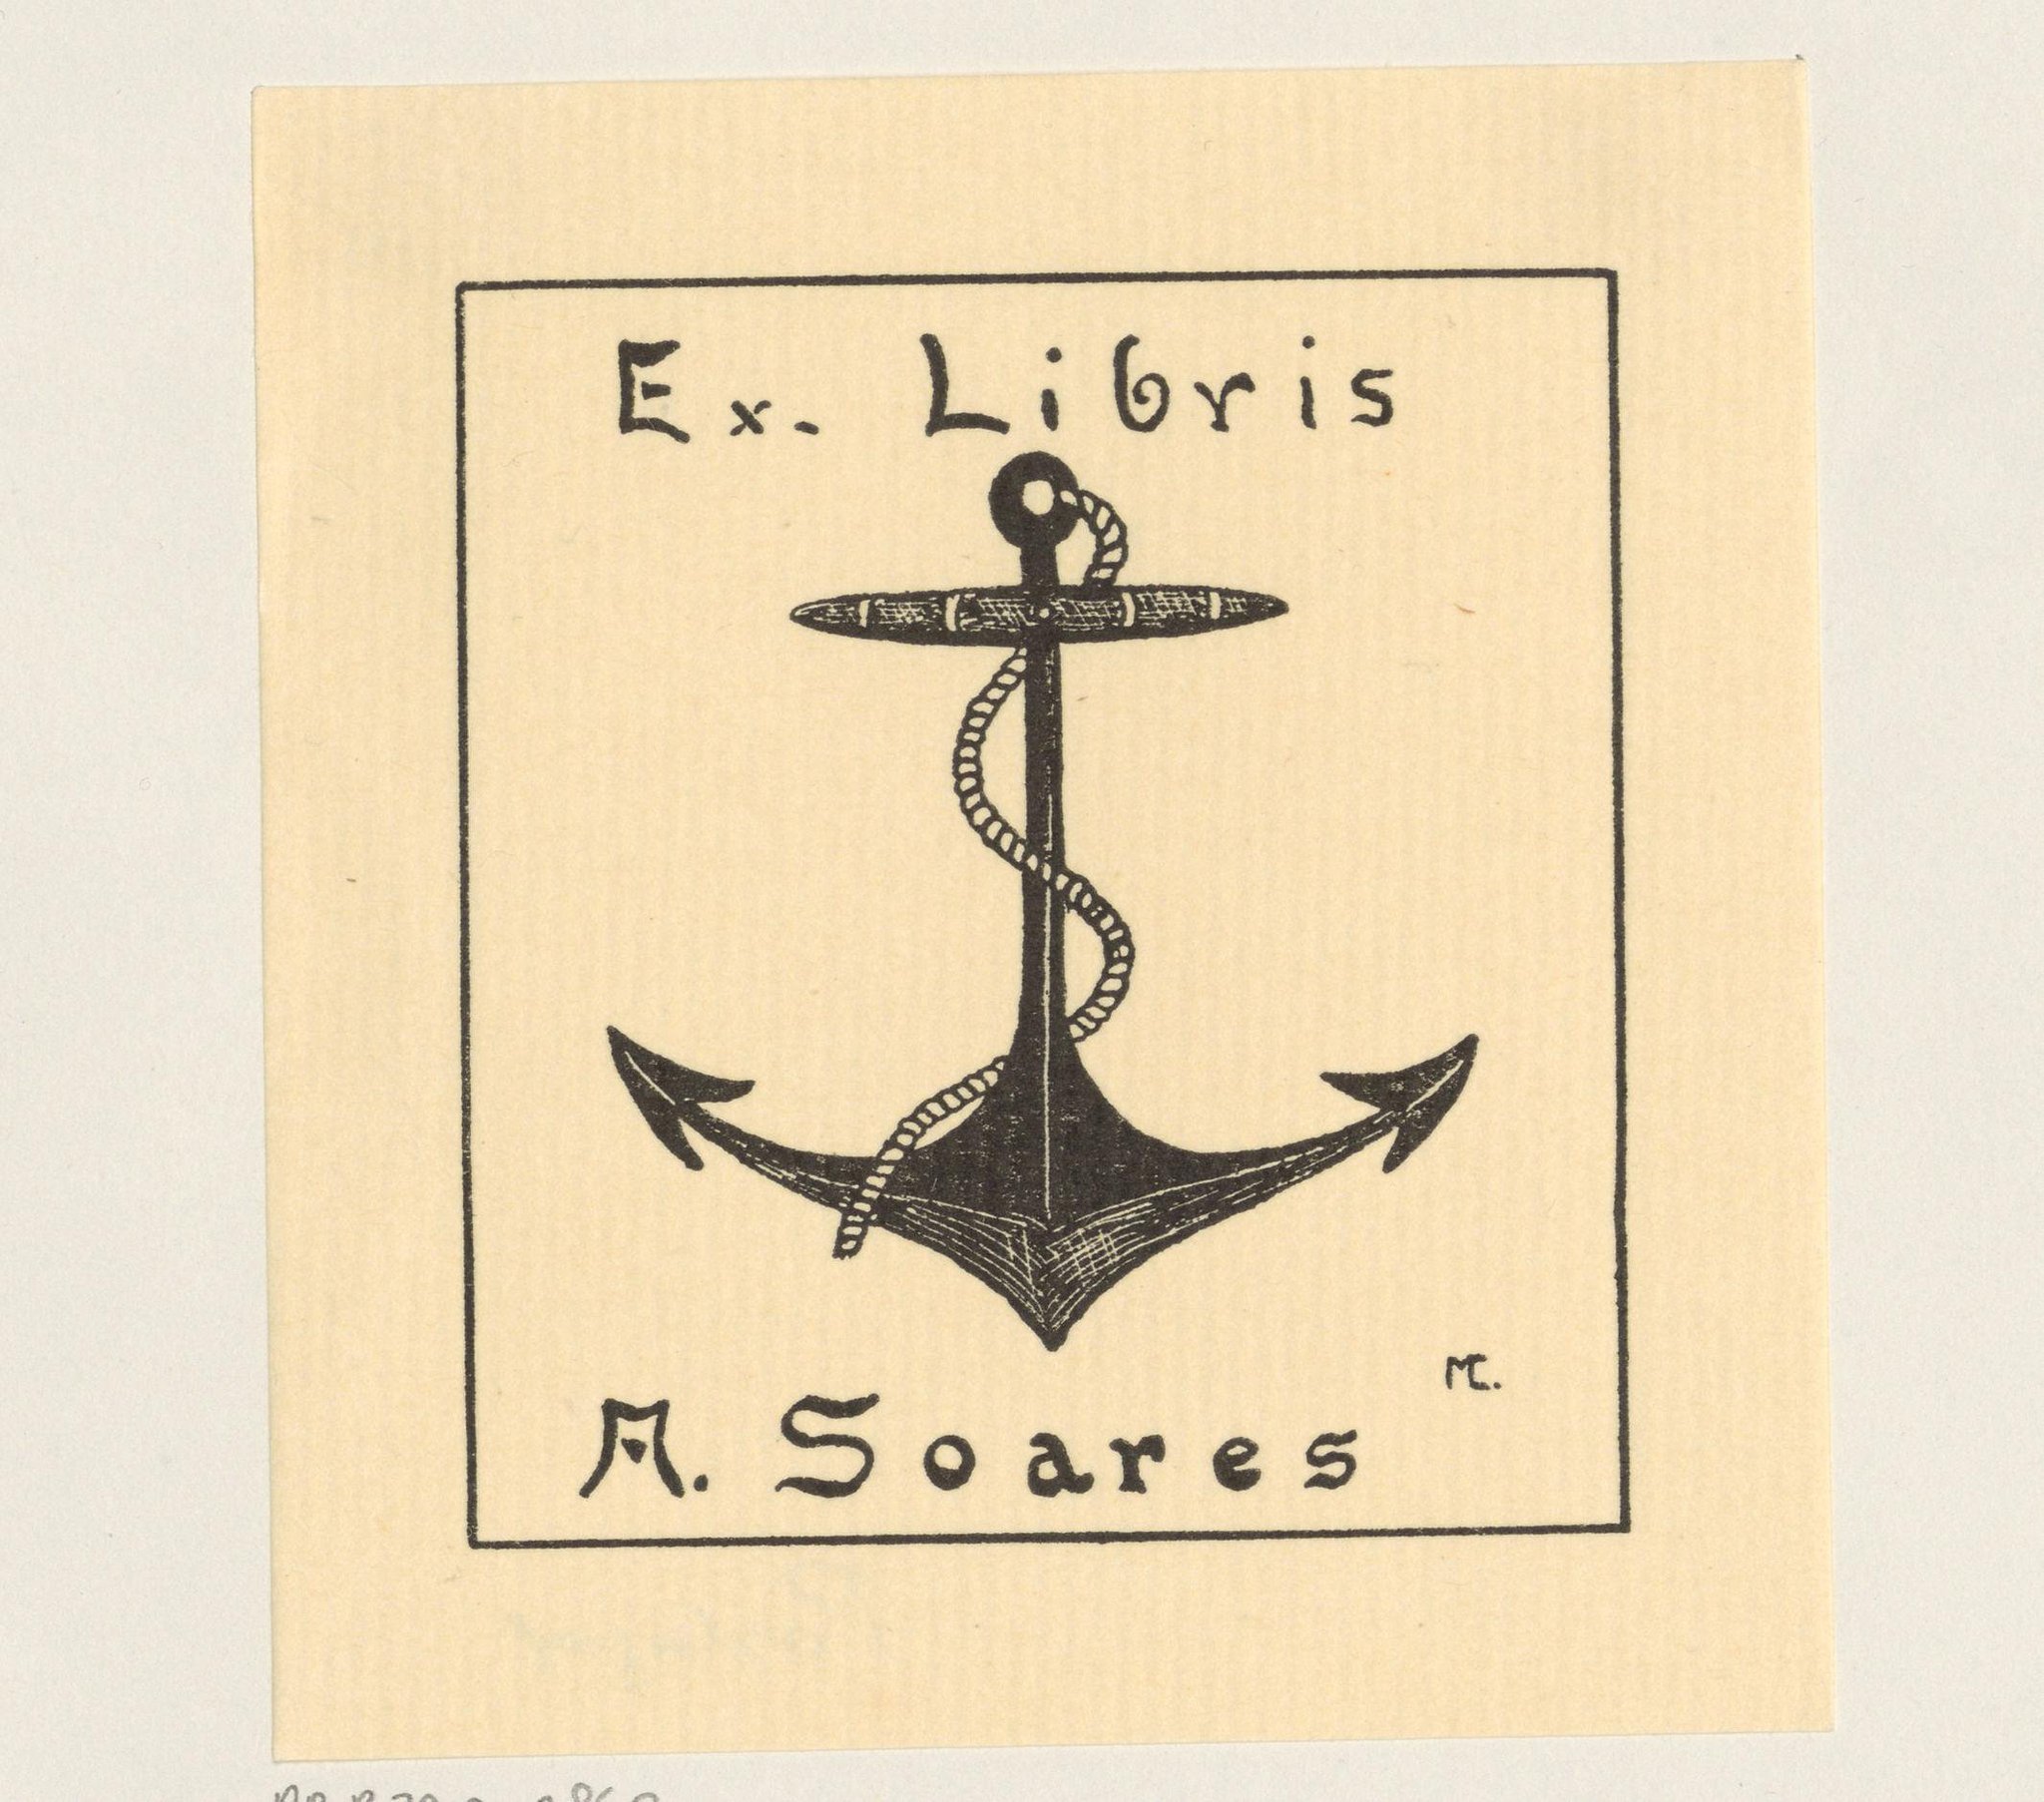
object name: bookplate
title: Ex libris van A. Soares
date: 1900-1999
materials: paper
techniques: printing block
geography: portugal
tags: parts of ship's exterior: anchor